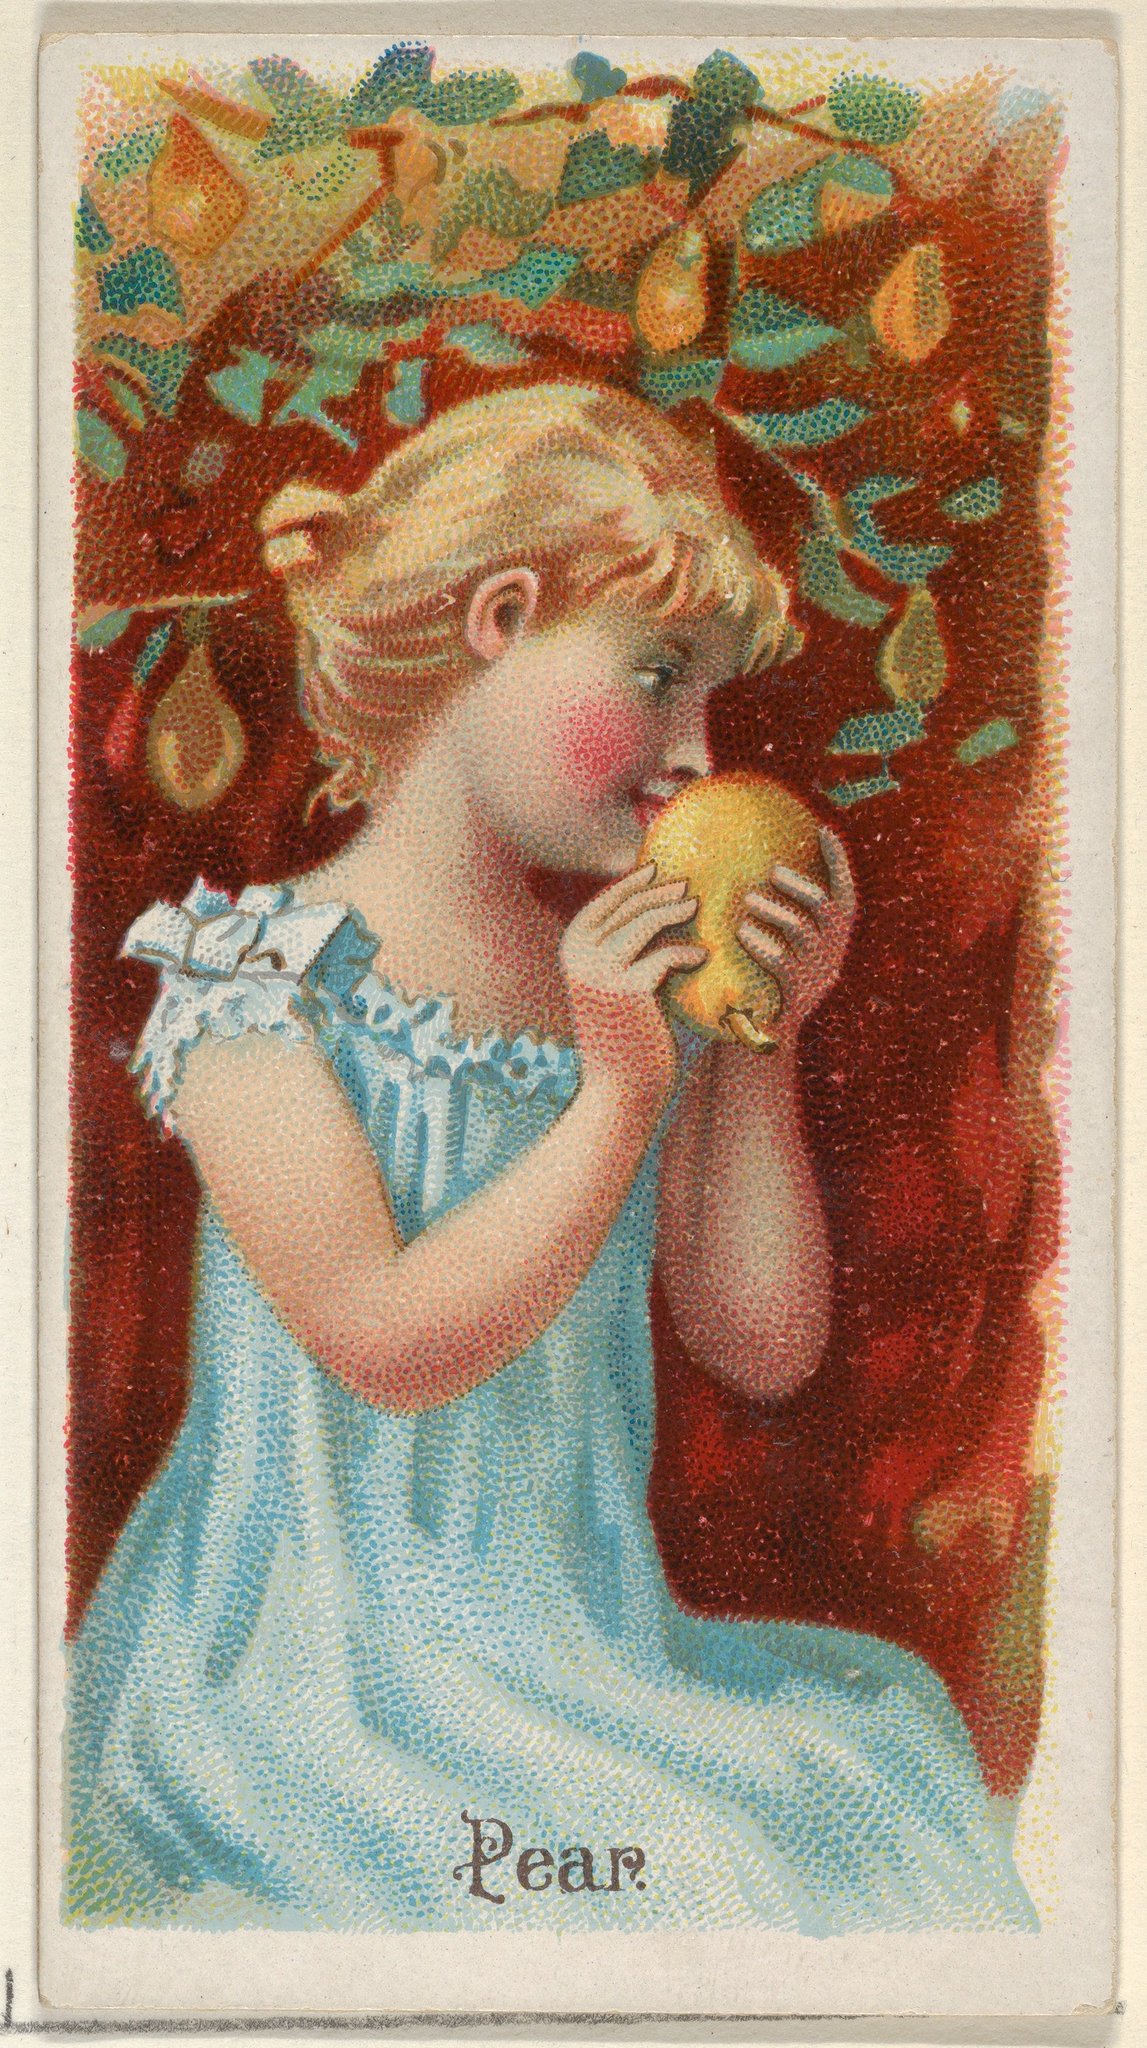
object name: print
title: Pear, from the Fruits series (N12) for Allen & Ginter Cigarettes Brands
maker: allen & ginter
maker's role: publisher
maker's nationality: american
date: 1891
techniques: color lithograph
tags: pears,girls,profiles